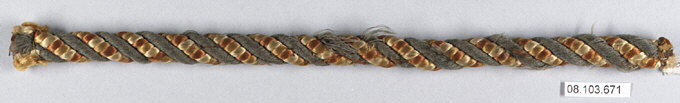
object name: cord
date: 1801-1900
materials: silk, wool